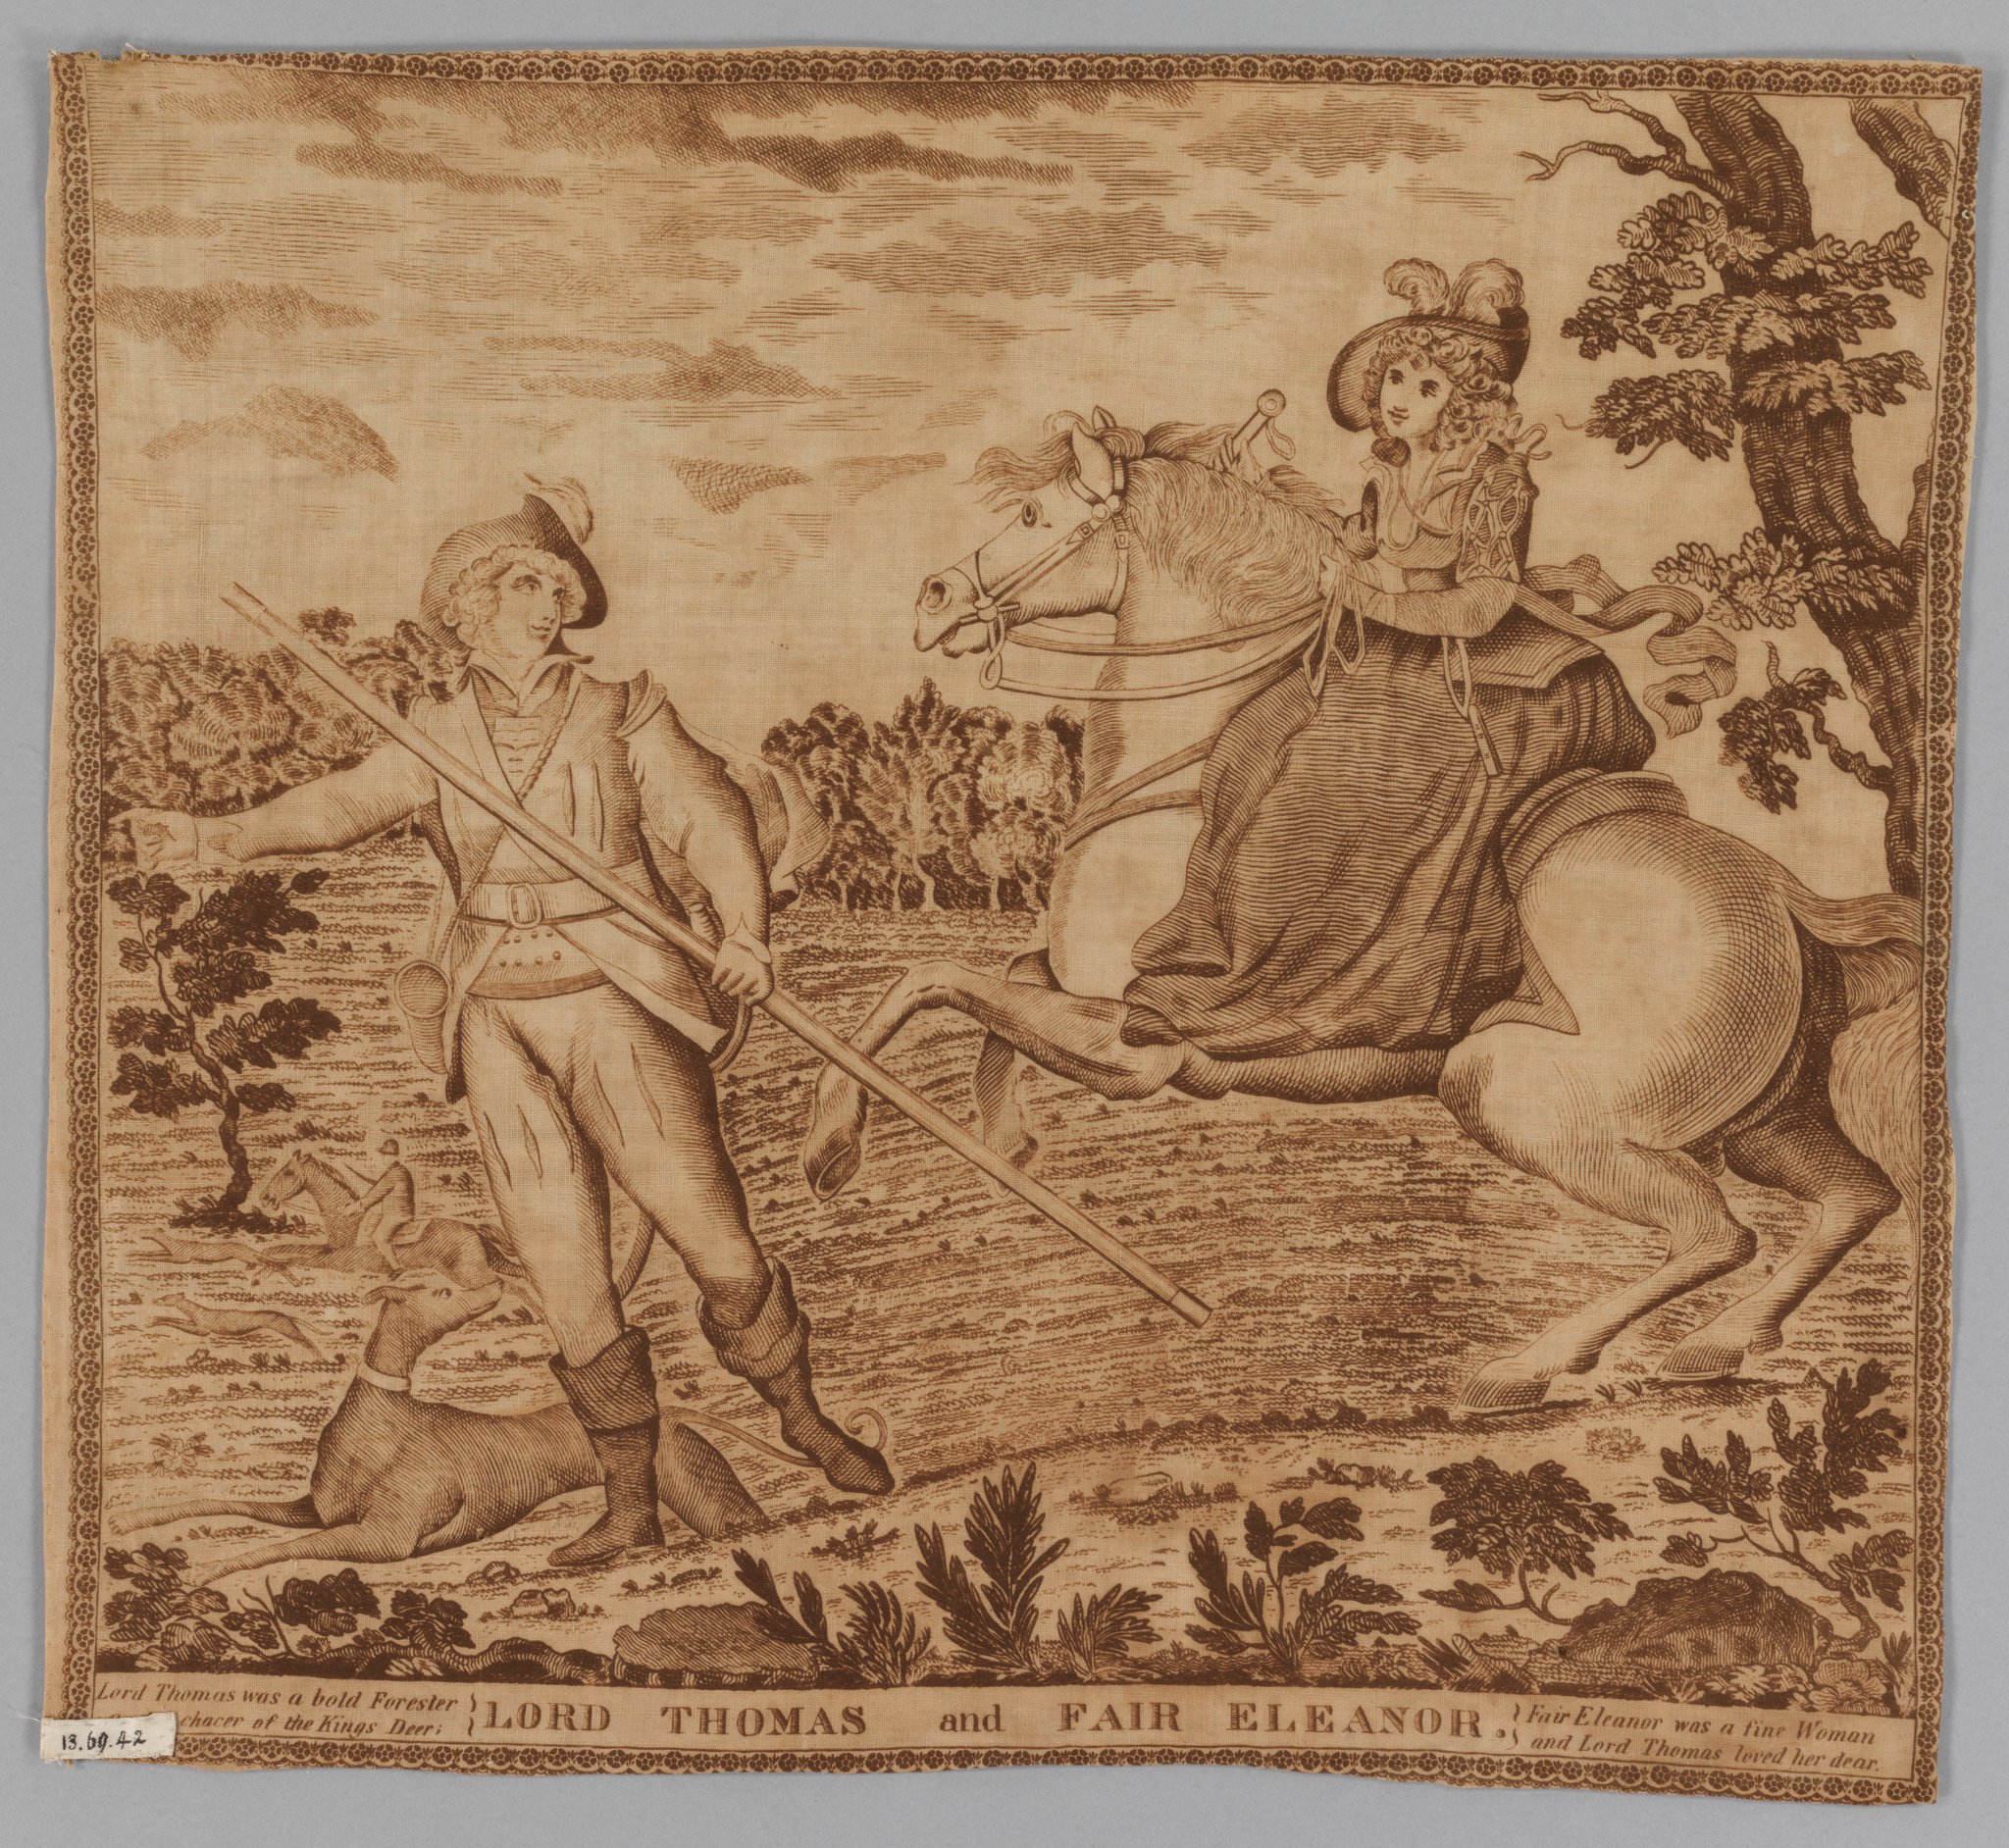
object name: handkerchief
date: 1767-1800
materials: cotton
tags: men,women,dogs,horses